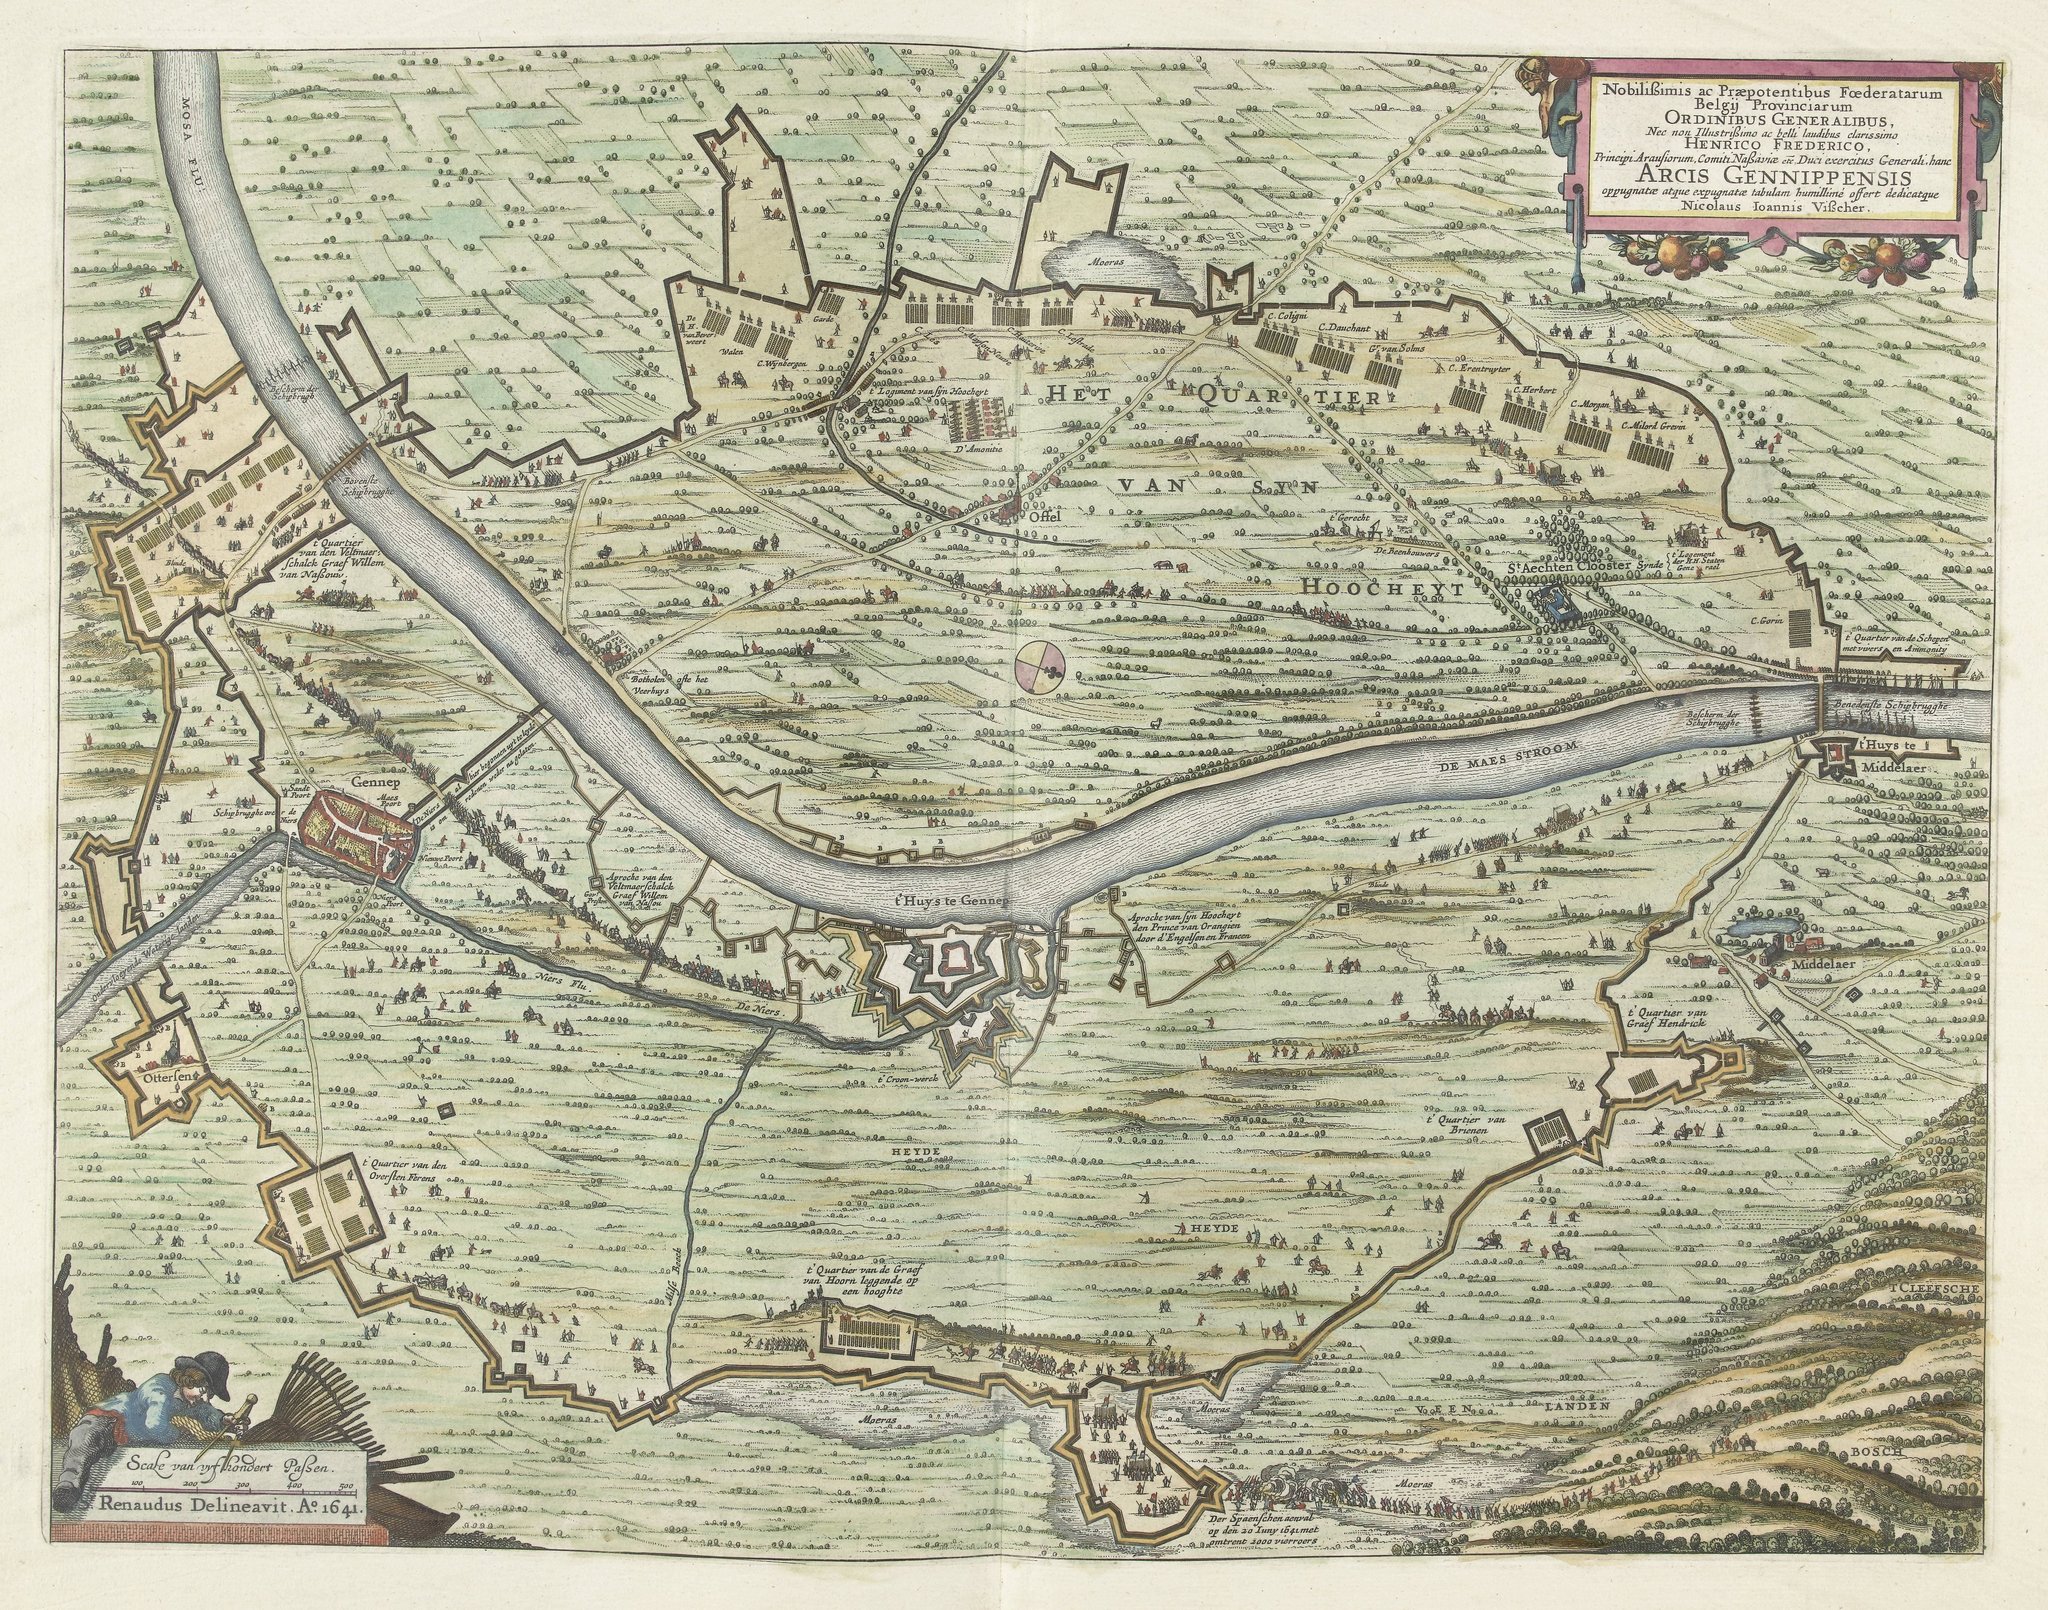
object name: print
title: Kaart van het beleg van Gennep, 1641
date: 1641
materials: paper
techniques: etching, hand coloring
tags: frederick henry (prince of orange), maps of separate countries or regions, siege, position war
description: Kaart van Gennep met het Huis te Gennep en omgeving, belegerd en veroverd door het Staatse leger onder Frederik Hendrik, 6 juni - 27 juli 1641. Met de circumvallatielinie van de belegeraars en de hun legerkampen. Op een dubbelblad genomen uit het Stedenboek van Blaeu. Bedrukt op de achterzijde met tekst in het Nederlands.